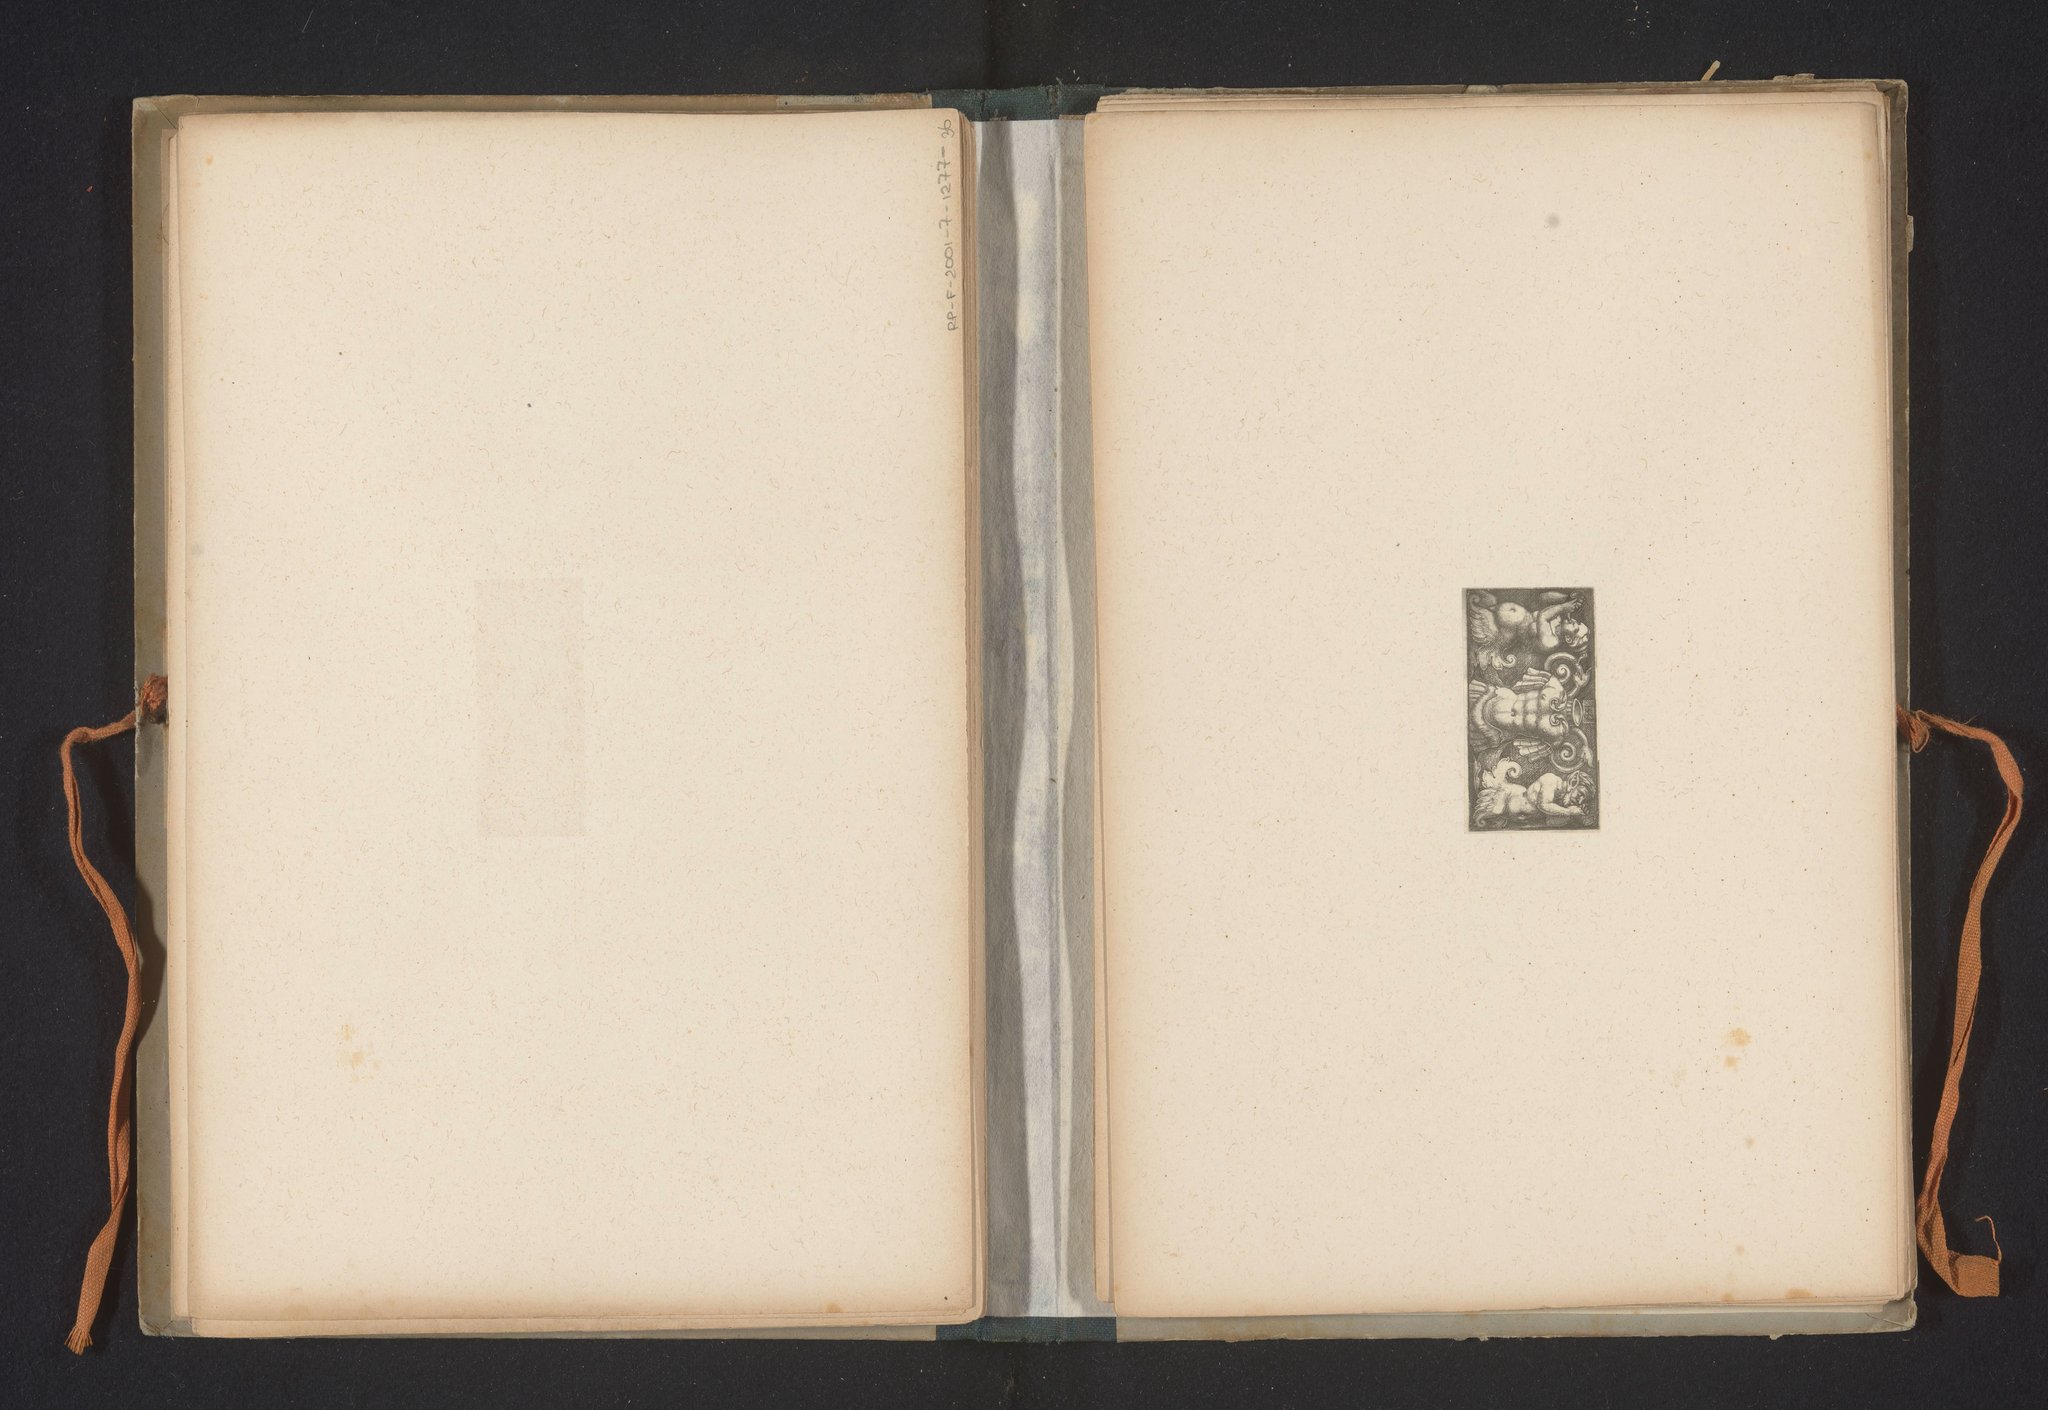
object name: photomechanical print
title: Reproductie van een prent van groteske ornamenten door Hans Sebald Beham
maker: hans sebald beham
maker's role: designer, draughtsman, print maker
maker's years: 1500-1550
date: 1866-1871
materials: paper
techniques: woodburytype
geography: brussels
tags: ornament ~ grotesque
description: Deze prent maakt deel uit van een omslag met 57 prenten op 54 bladen.